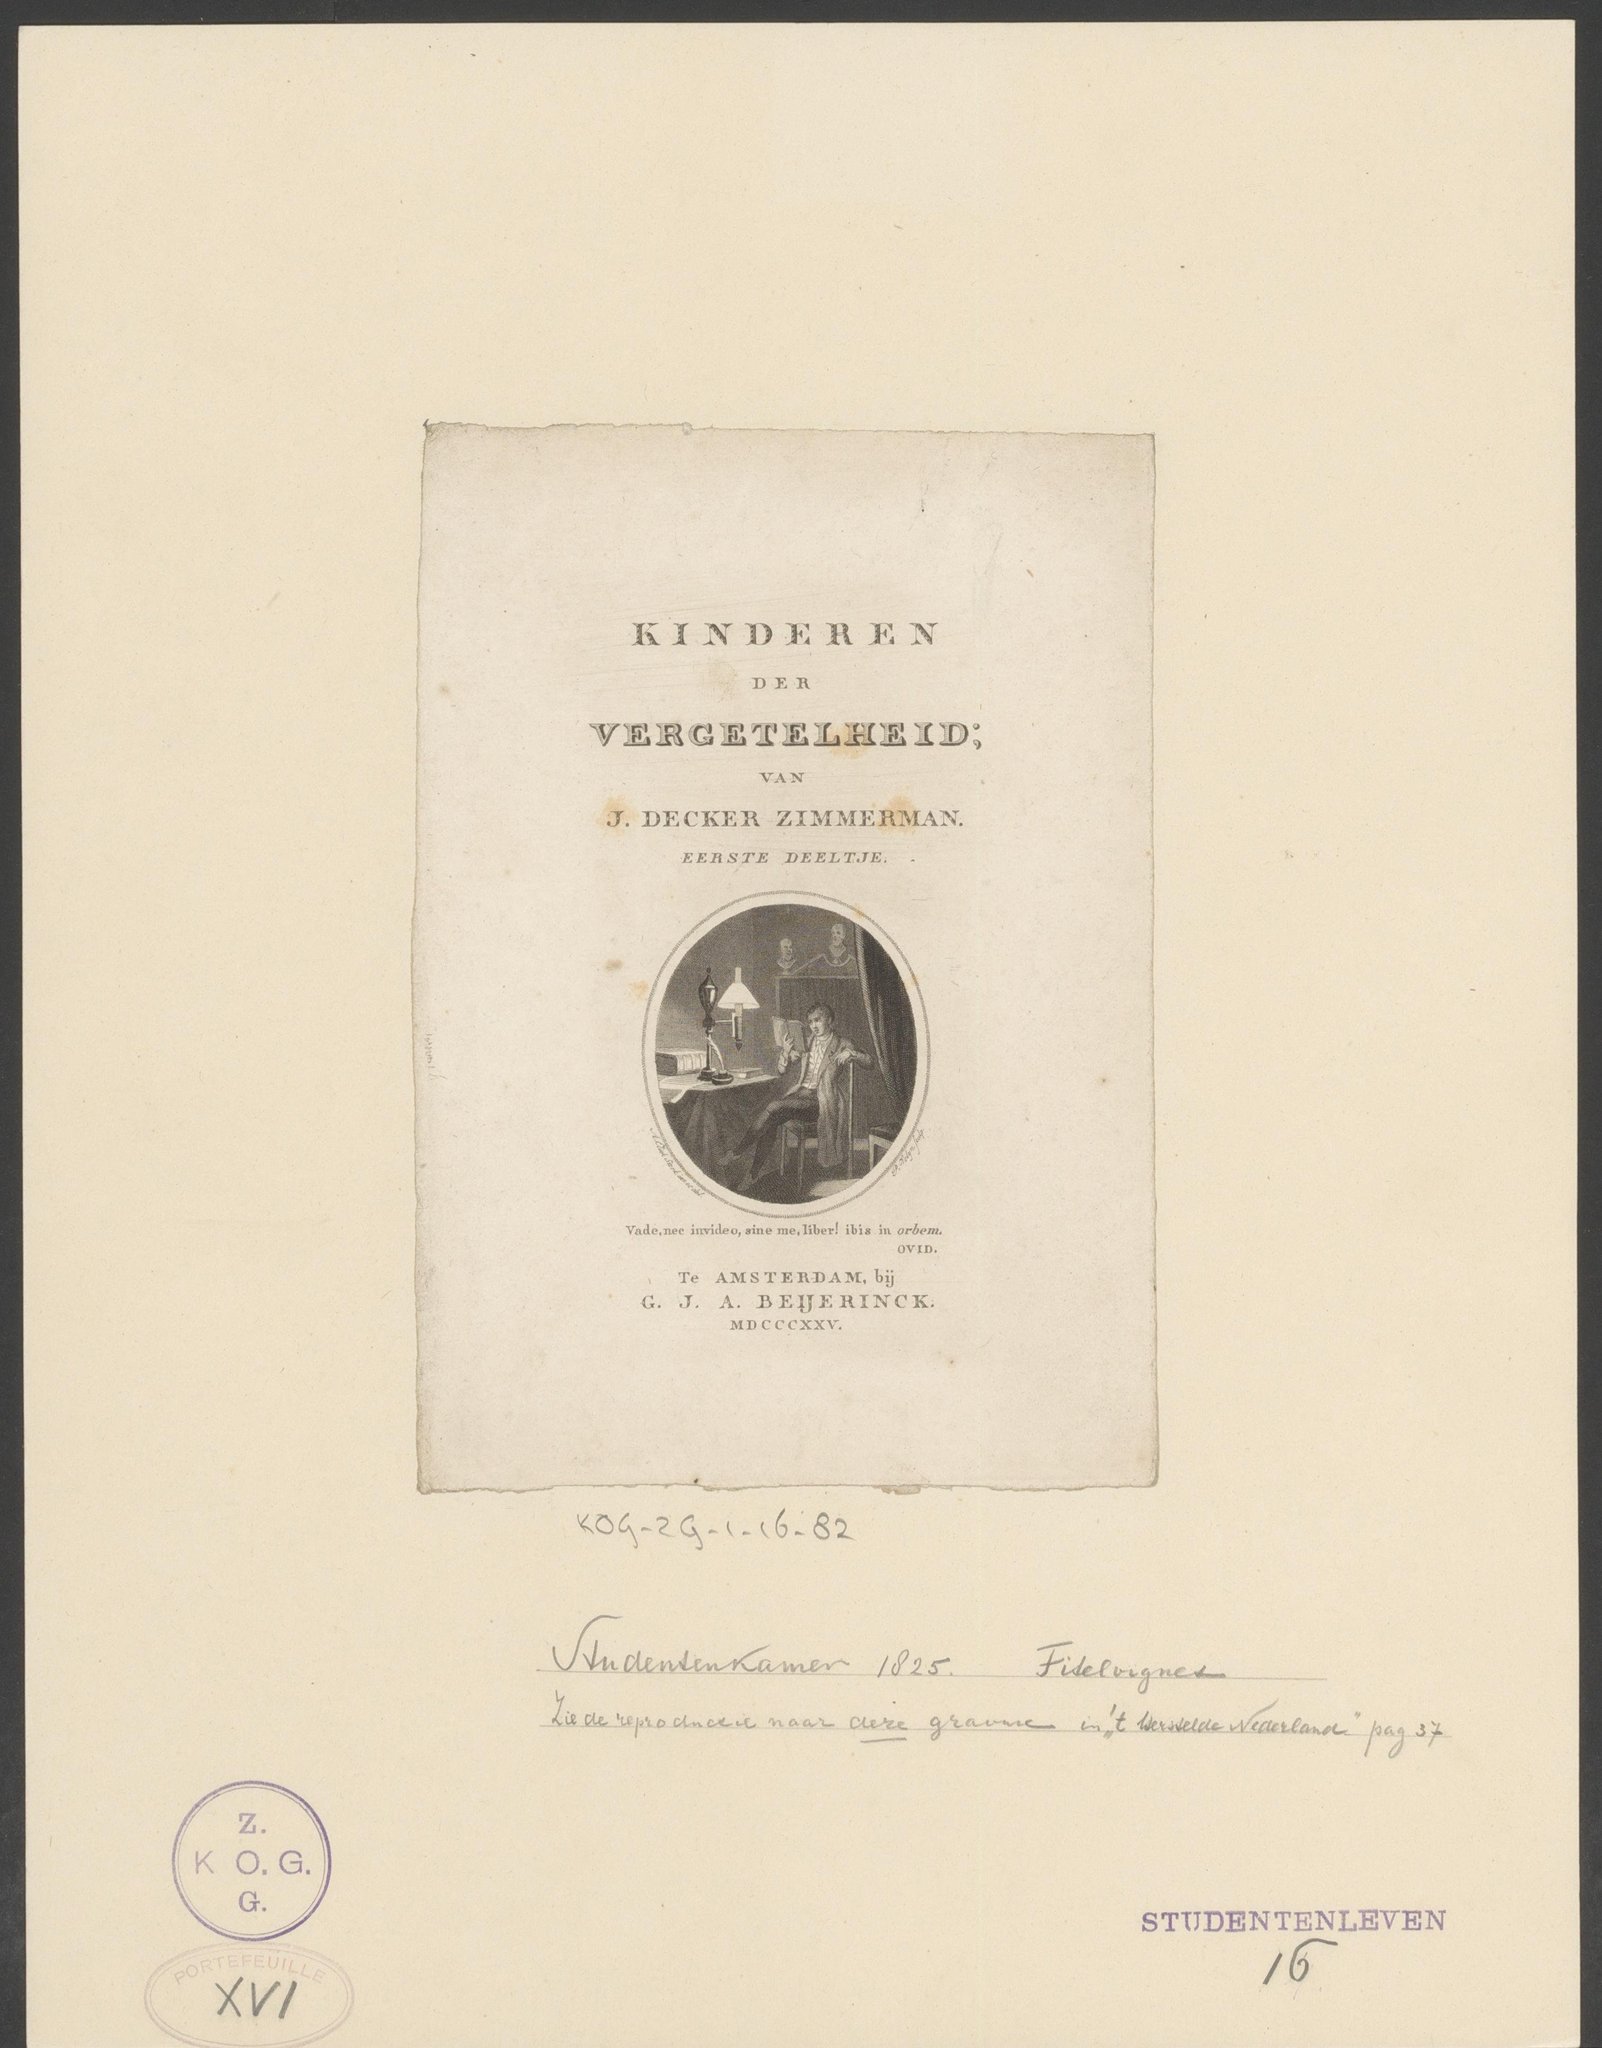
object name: titelprent, frontispice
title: Student in zijn studeerkamer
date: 1825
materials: paper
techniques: engraving, etching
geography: amsterdam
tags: student life, studying at night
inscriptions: collector's mark: Lugt 1641, stamp, stamp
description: Titelpagina voor: J. Decker Zimmerman. Kinderen der vergetelheid. Amsterdam: Gerrit Jan Adriaan Beijerinck, 1825.